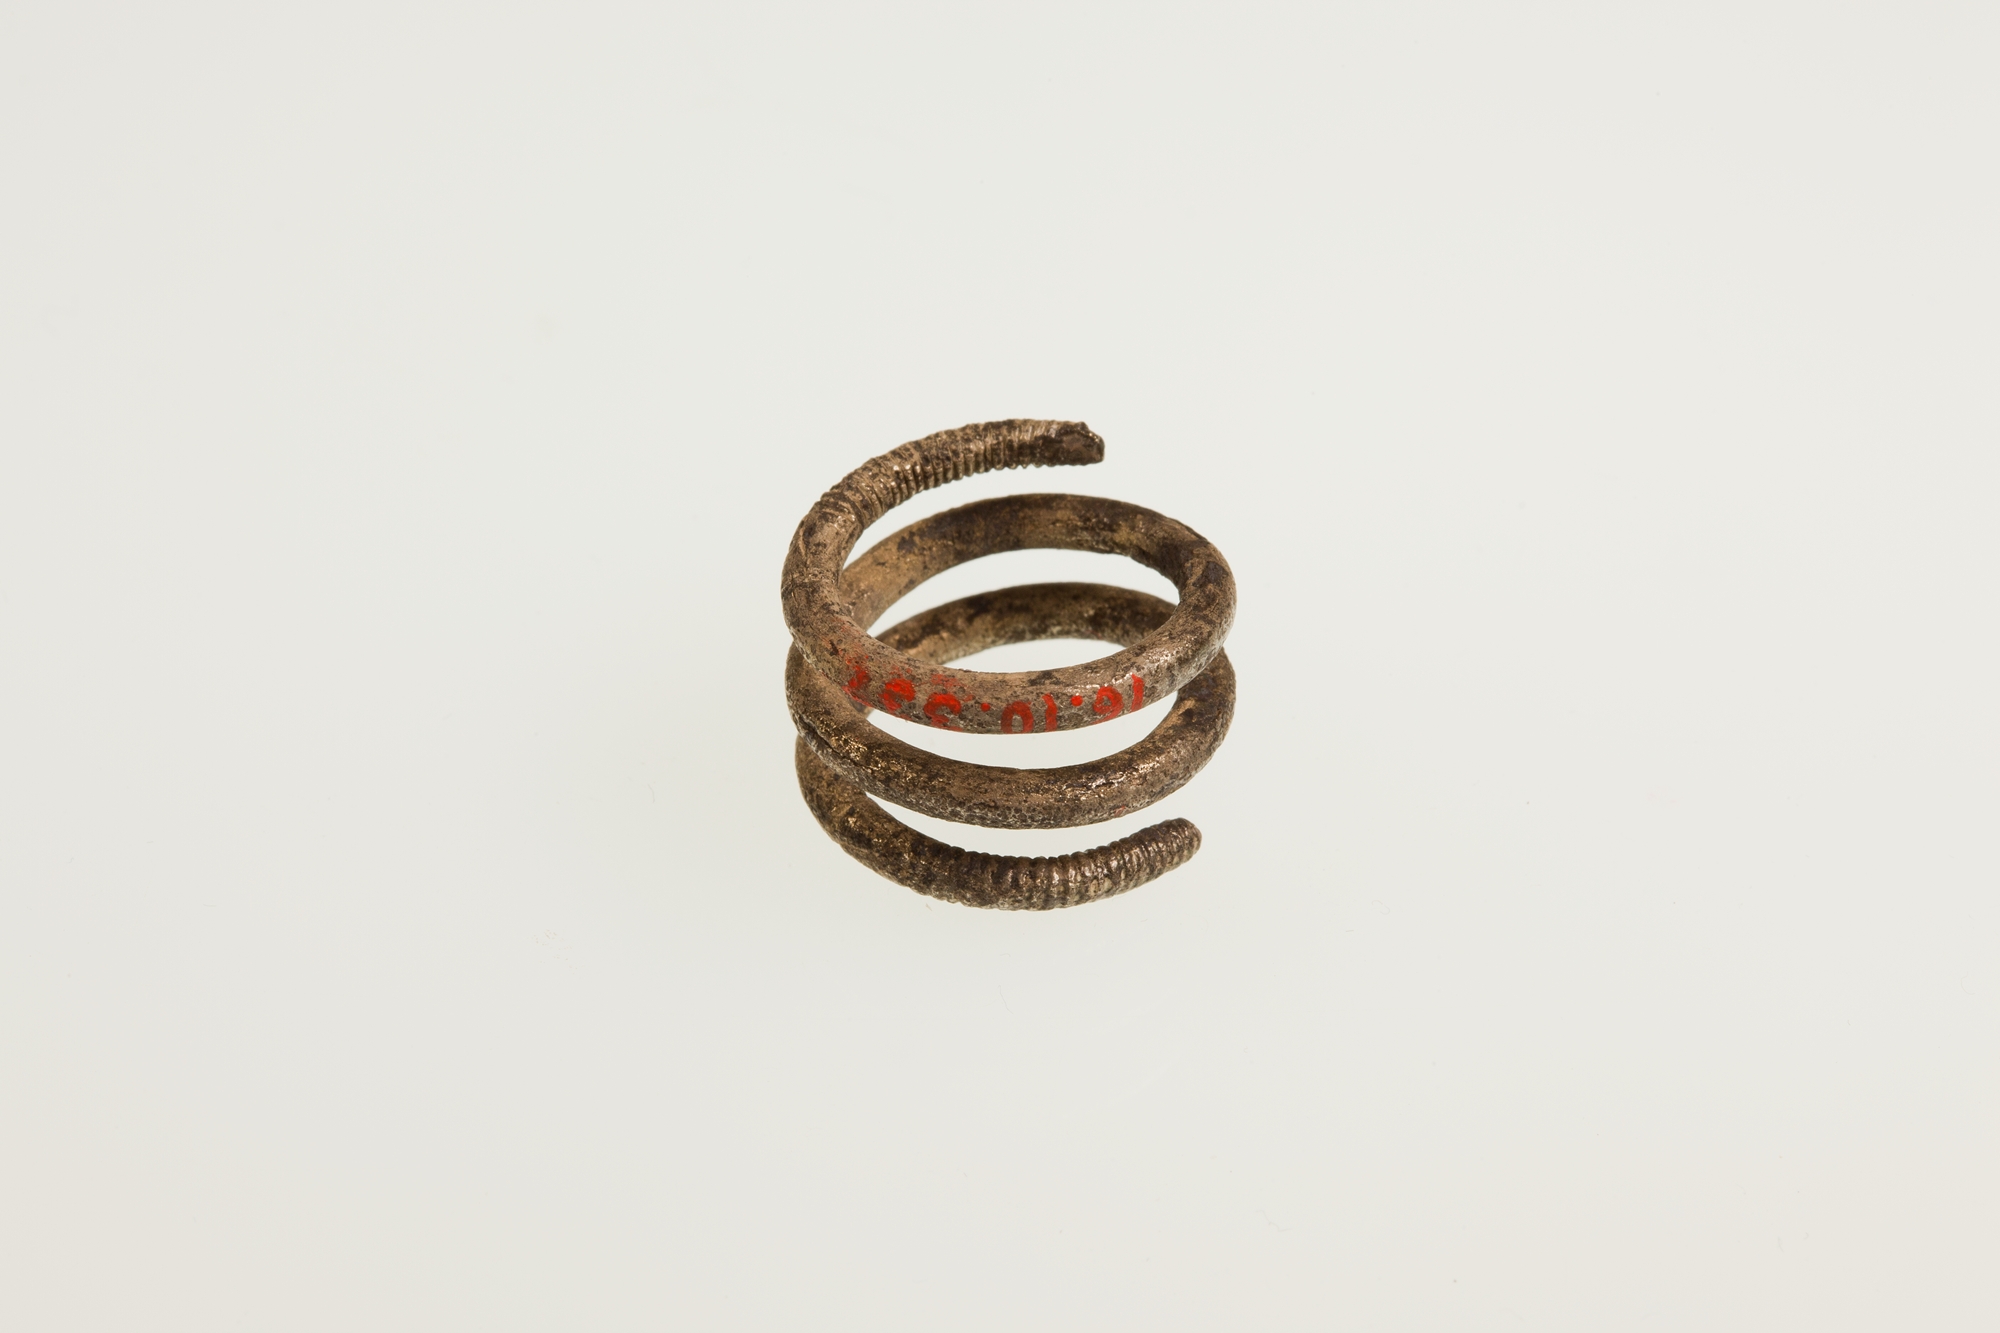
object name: earring or spiral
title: Pair of Earrings (with 16.10.338)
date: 1635-1458 BCE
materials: silver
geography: egypt